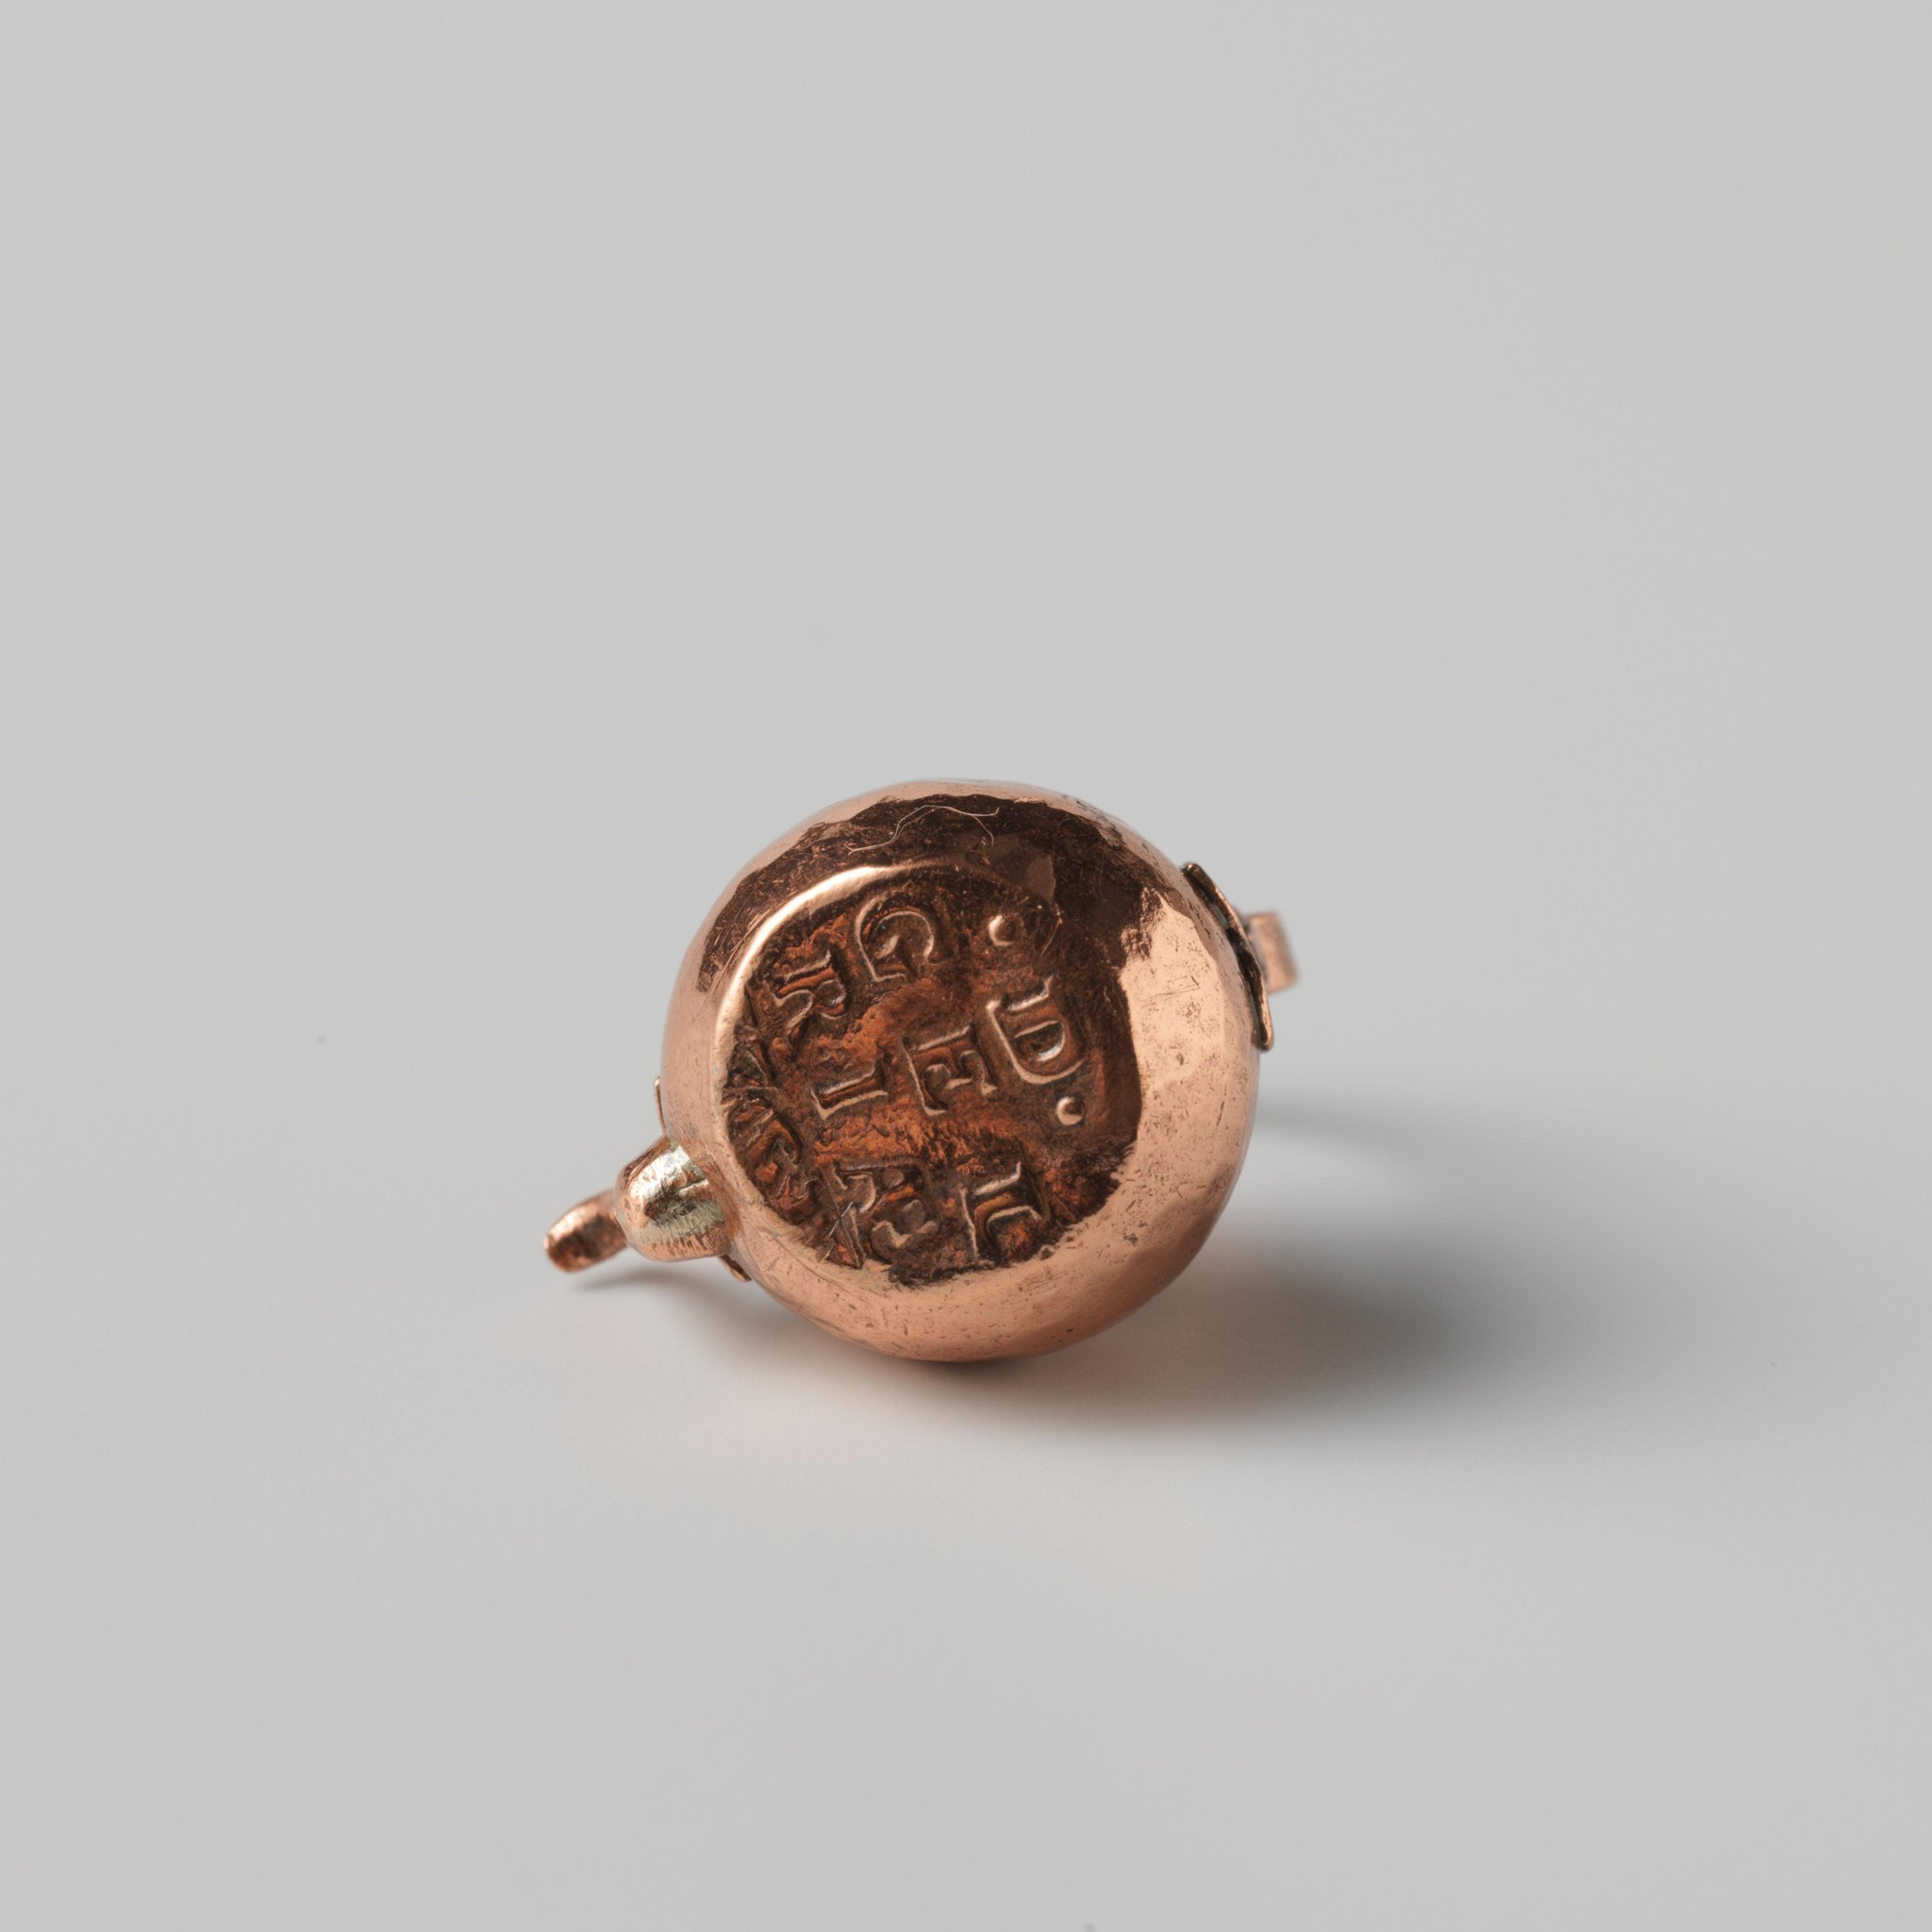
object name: teakettle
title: Waterketel, geslagen uit een Gelderse duit van 1760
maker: Anonymous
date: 1760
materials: brass, copper, metal alloy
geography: amsterdam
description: Waterketel van koper, van binnen vertind; geslagen uit Gelderse munt van 1760. Op onderzijde een wapen en jaartal.